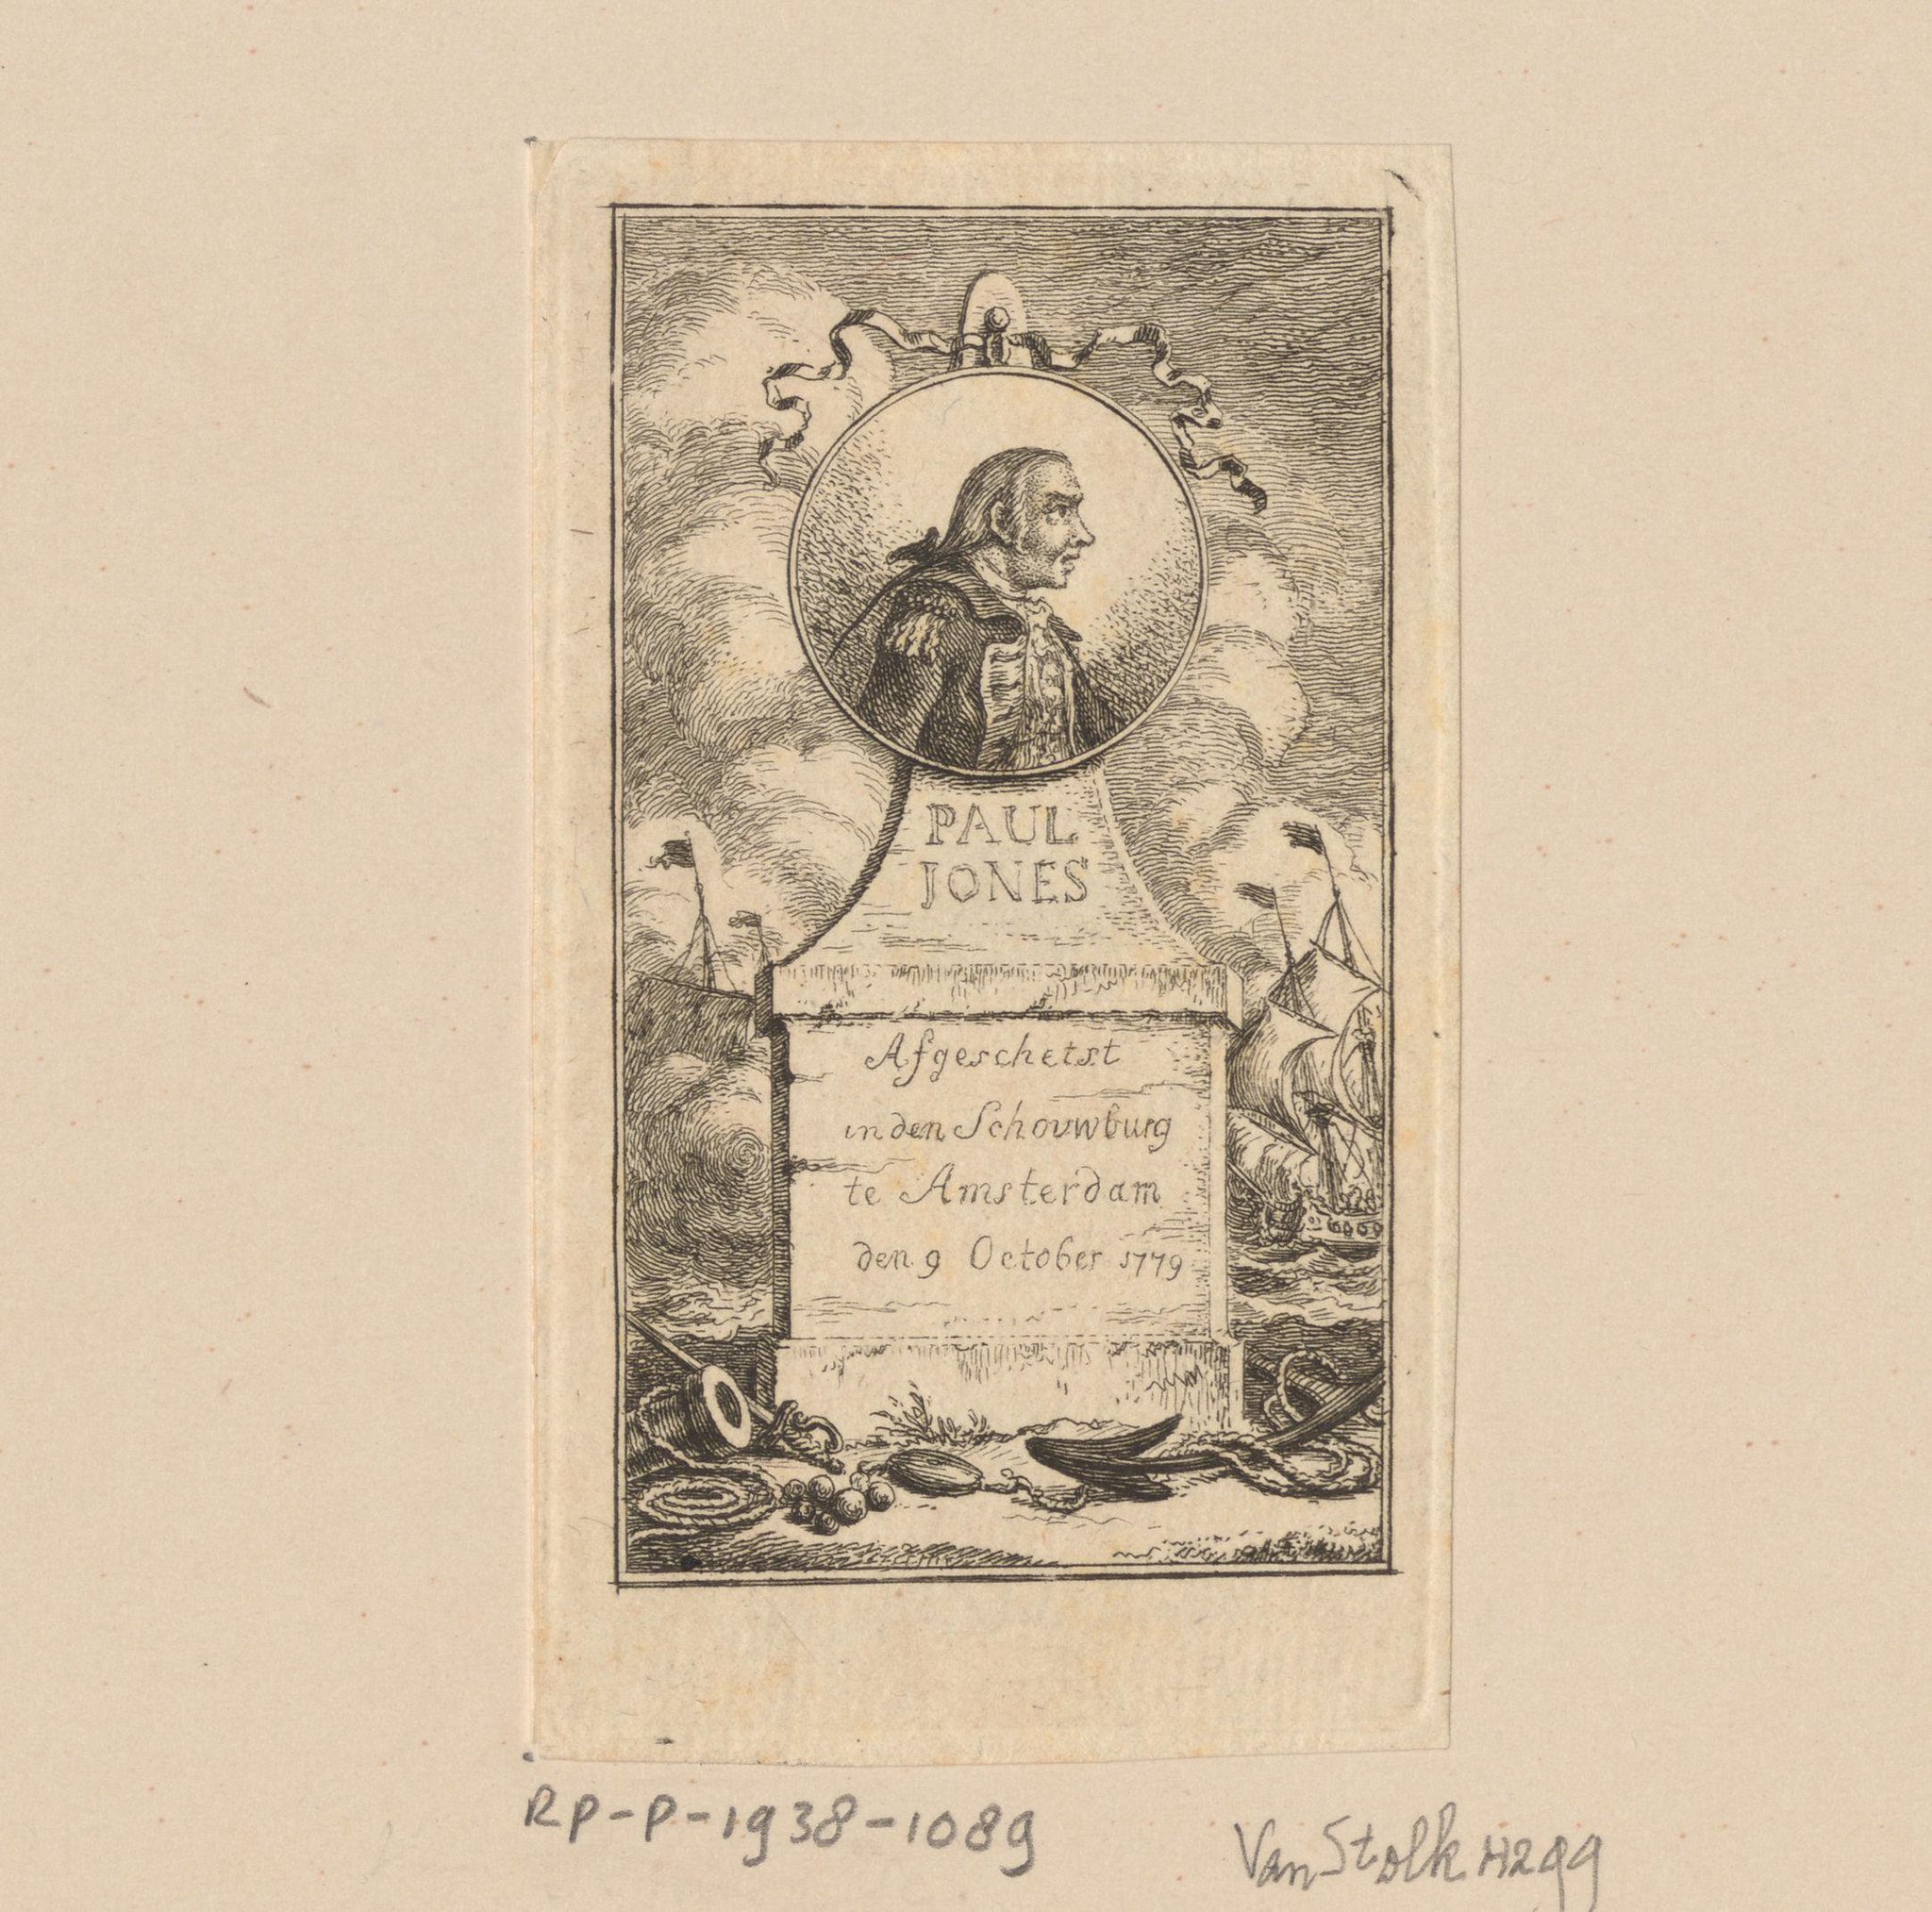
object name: print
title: Portret van John Paul Jones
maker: Anonymous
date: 1779-1796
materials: paper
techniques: etching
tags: capuche, historical persons, ships (in general)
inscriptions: collector's mark: Lugt 2228, collector's mark: Lugt 2760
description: Prent mogelijk uit: Fokke, Arend. De vaderlandsche historie in themata. Amsterdam: A.B. Saakes, 1796.